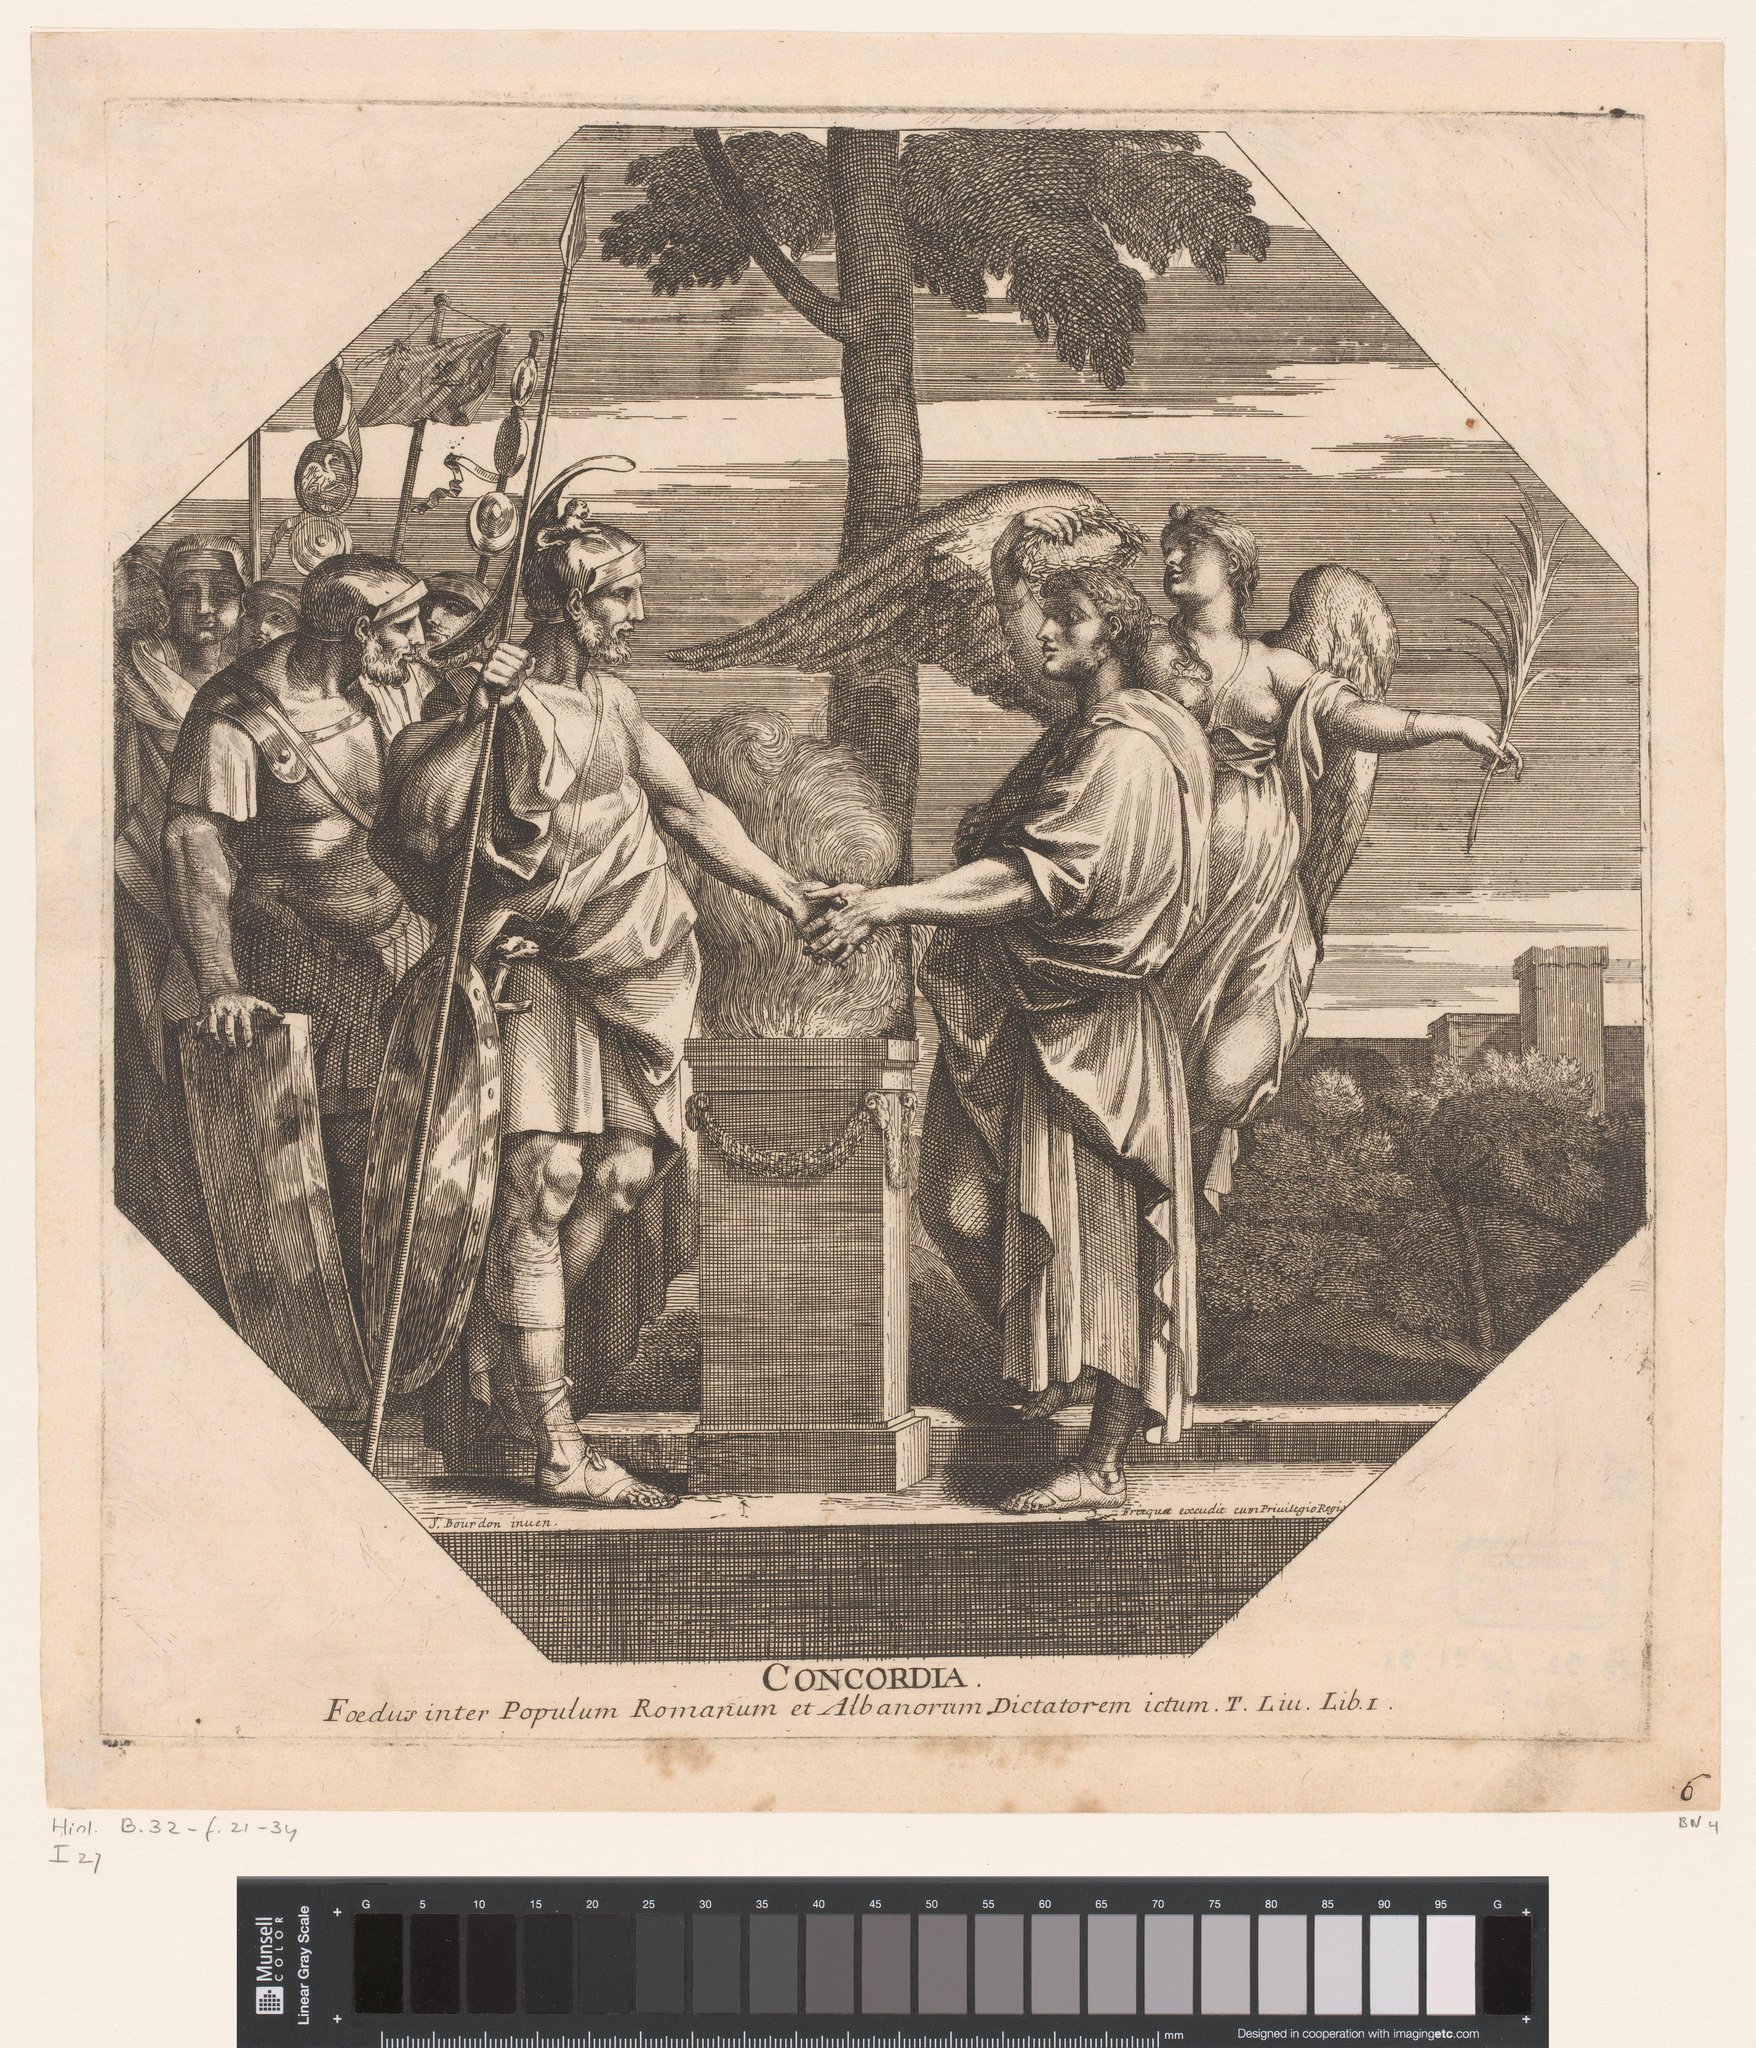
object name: print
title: Eendracht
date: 1663-1716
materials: paper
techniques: engraving, etching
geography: france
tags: concord, 'concordia' ~ one of the seven gifts of the soul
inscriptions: number: ‘6’, collector's mark: Lugt 11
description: Maakt deel uit van een veertiendelige serie opgedeeld in twee reeksen, met als onderwerp de zeven vrije kunsten en deugden naar schilderijen door Sébastien Bourdon. De schilderijen werden in 1663 vervaardigd voor de Grande Galerie van het Hôtel de Bretonvilliers te Parijs.